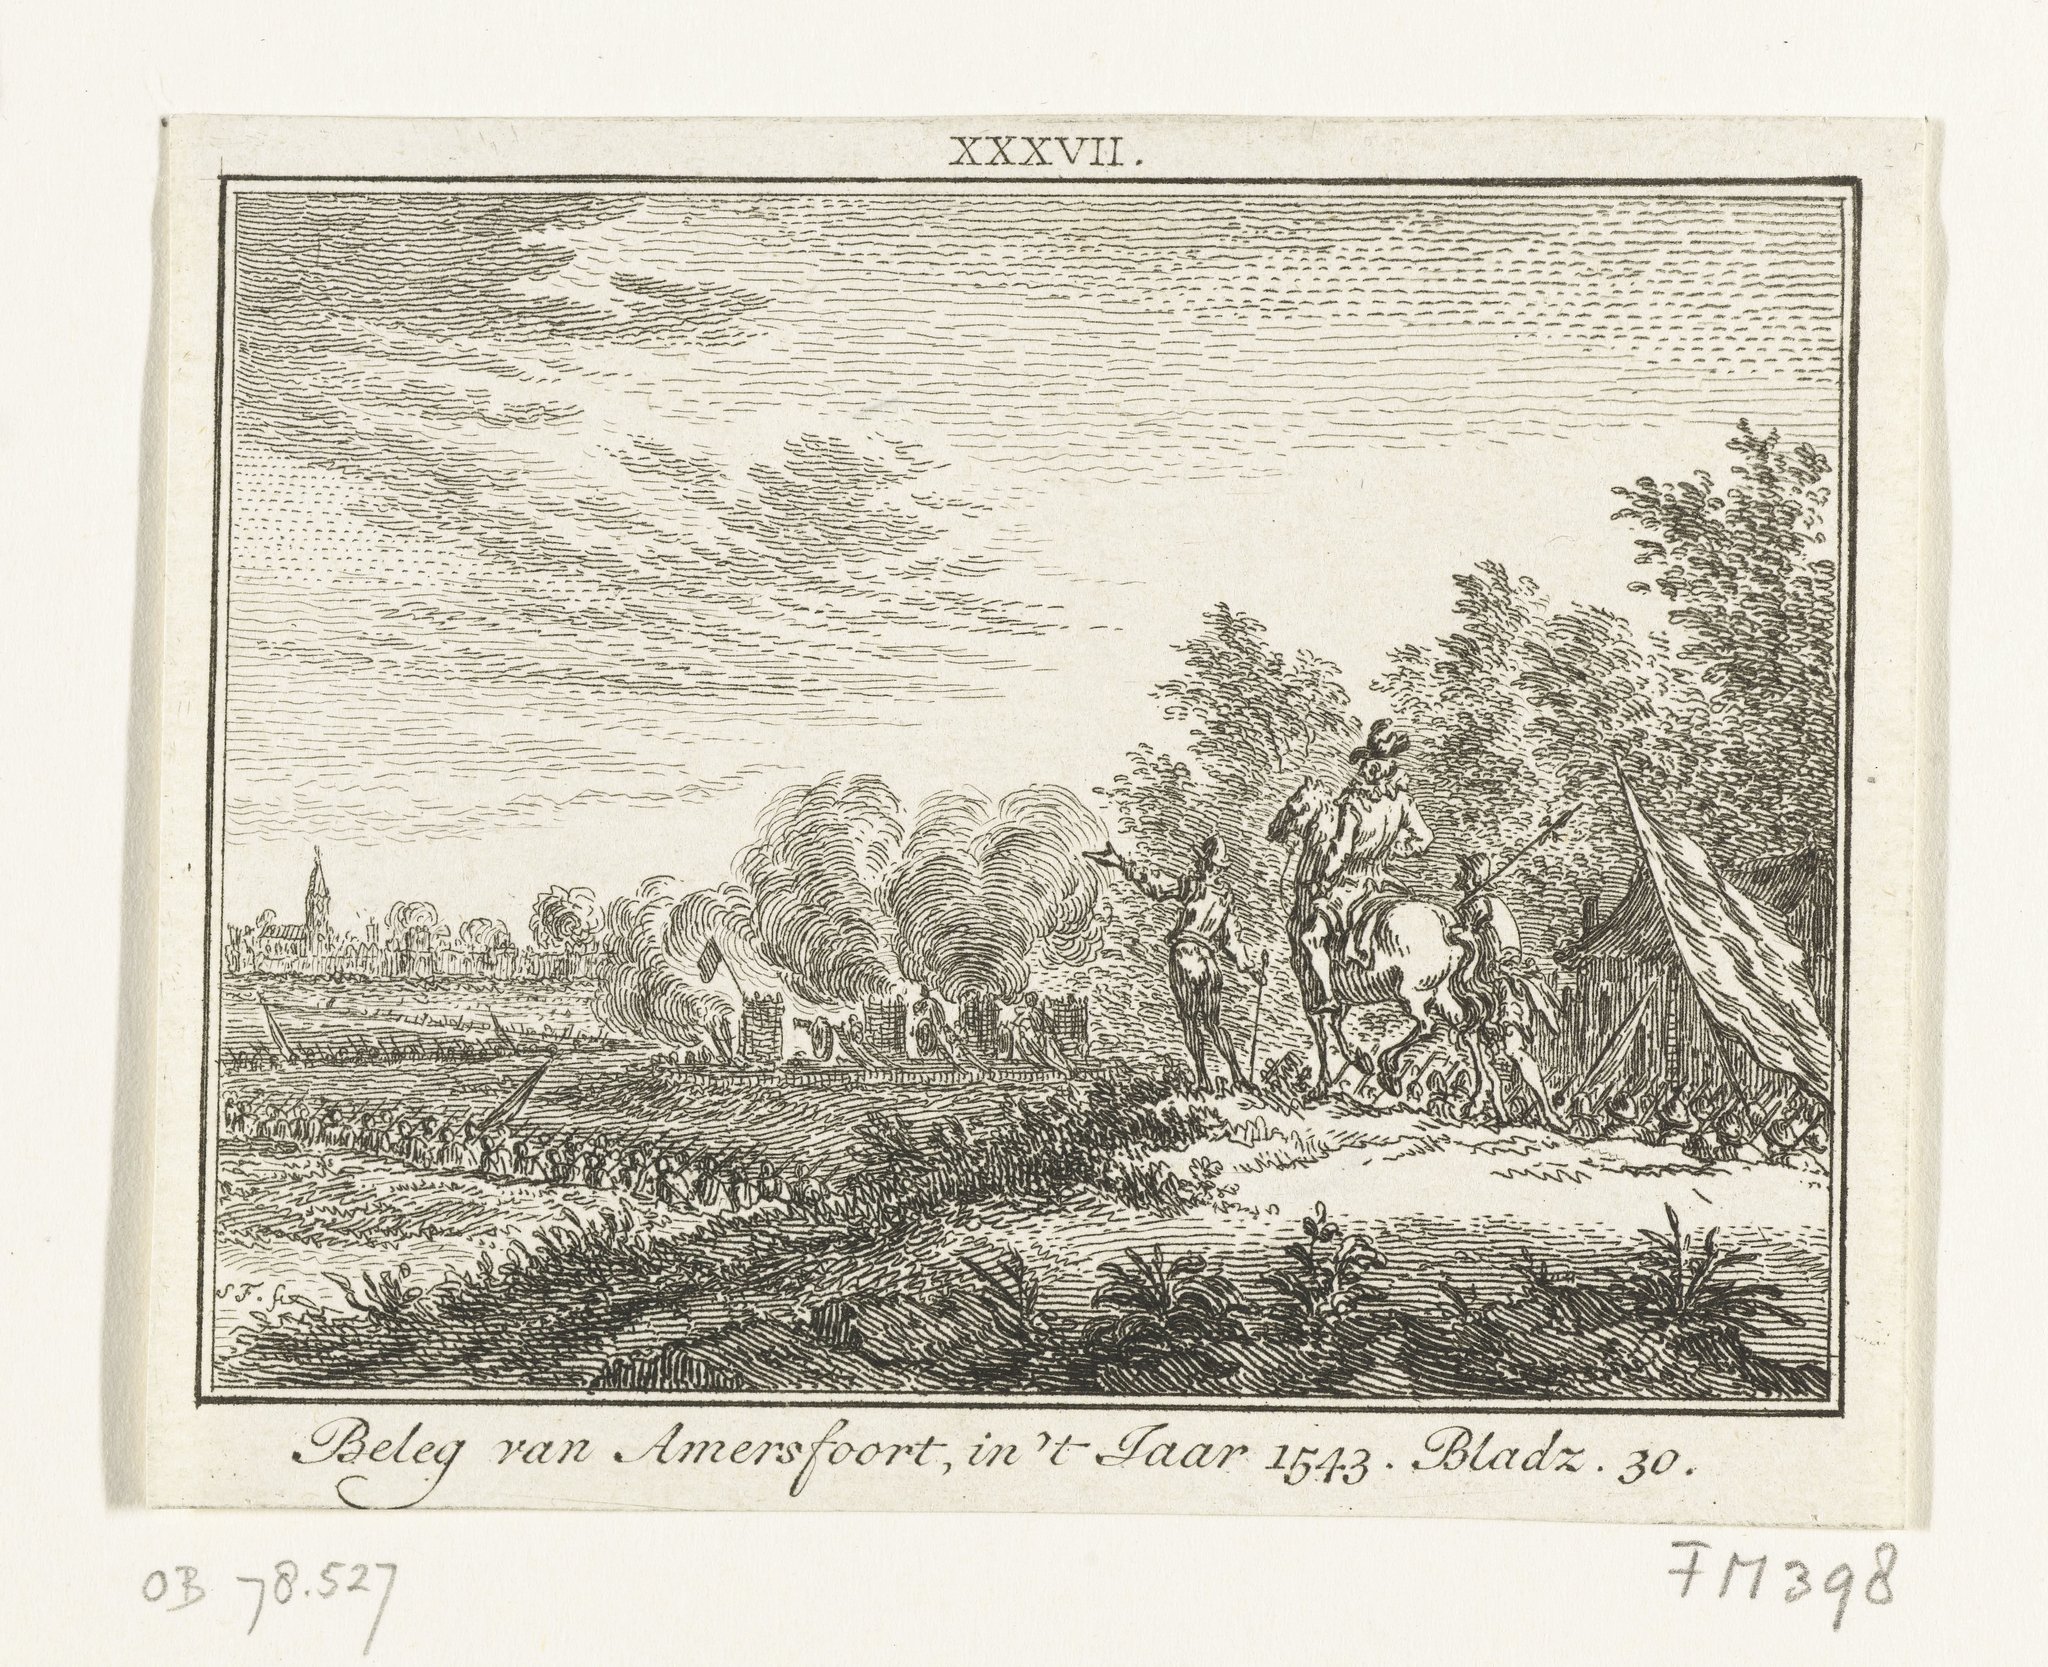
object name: print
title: Beleg van Amersfoort, 1543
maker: simon fokke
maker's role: draughtsman, print maker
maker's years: 1712-1784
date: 1782-1784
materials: paper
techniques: etching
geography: northern netherlands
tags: siege, position war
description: Illustratie voor: J.W. te Water, De vaderlandsche Historie van den heere J. Wagenaar, verkort, en met leerzaame aanmerkingen, ten dienste der Nederlandsche jeugd, 1784-1800, 4 delen, pl. XXXVII. Staat met de letter.